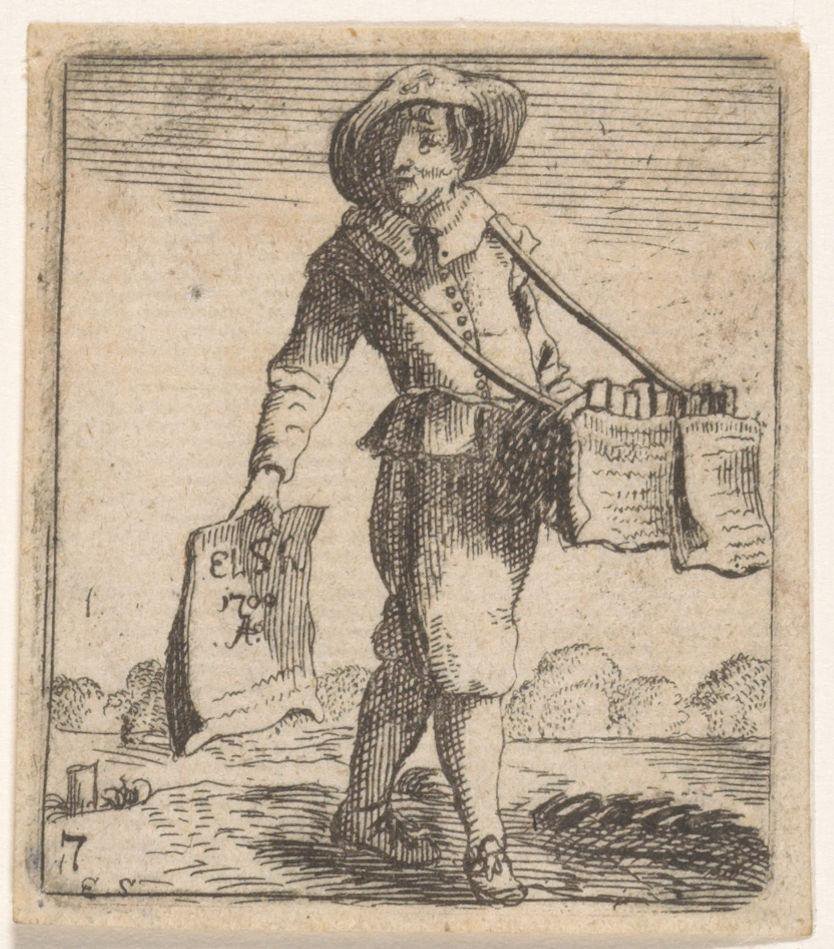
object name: print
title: Verkoper van boeken en prenten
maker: monogrammist es (18e eeuw)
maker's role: print maker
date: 1709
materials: paper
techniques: etching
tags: print, e.g.: engraving, etching, lithograph, book-shop, bookseller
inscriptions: collector's mark: Lugt 4780, collector's mark: Lugt 2228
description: Man met een mand met boeken en prenten in een landschap, in zijn rechterhand een blad.